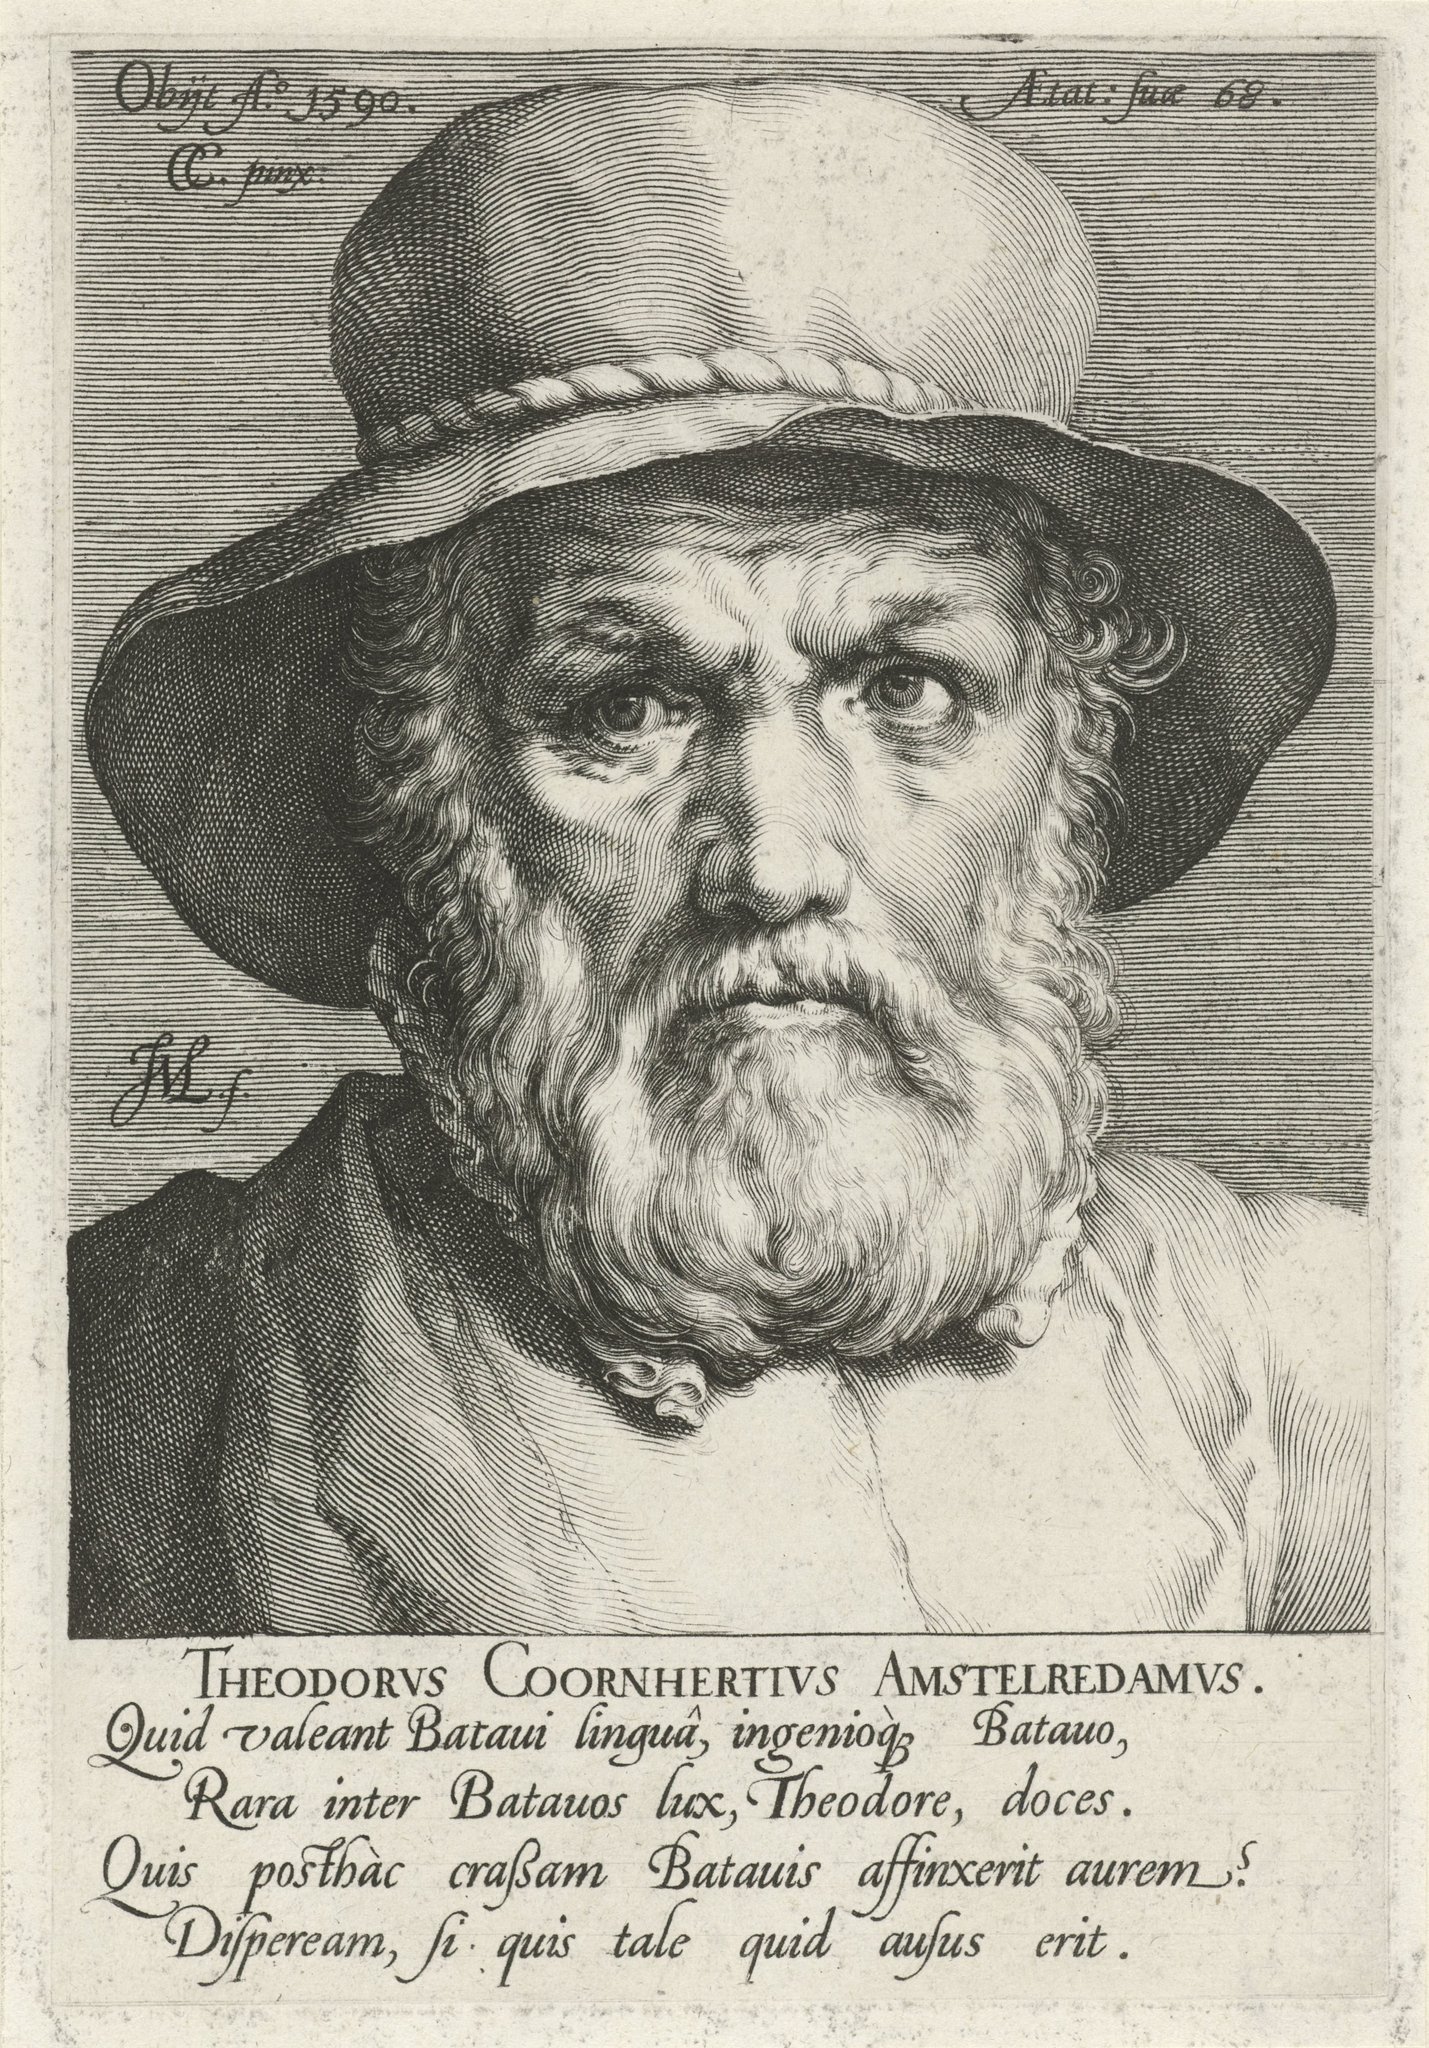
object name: print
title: Portret van Dirck Volckertsz. Coornhert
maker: jan harmensz. muller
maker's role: draughtsman, print maker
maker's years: 1571-1628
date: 1590-1592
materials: paper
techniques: engraving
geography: amsterdam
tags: amsterdam, print maker, draughtsman, dirck volckertsz. coornhert, portrait of a writer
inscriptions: collector's mark: Lugt 240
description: Portret van geleerde, schrijver en kunstenaar Dirck Volckertsz. Coornhert met een hoed op zijn hoofd. Onderaan in de marge zijn naam en een vierregelig vers over hem in het Latijn.